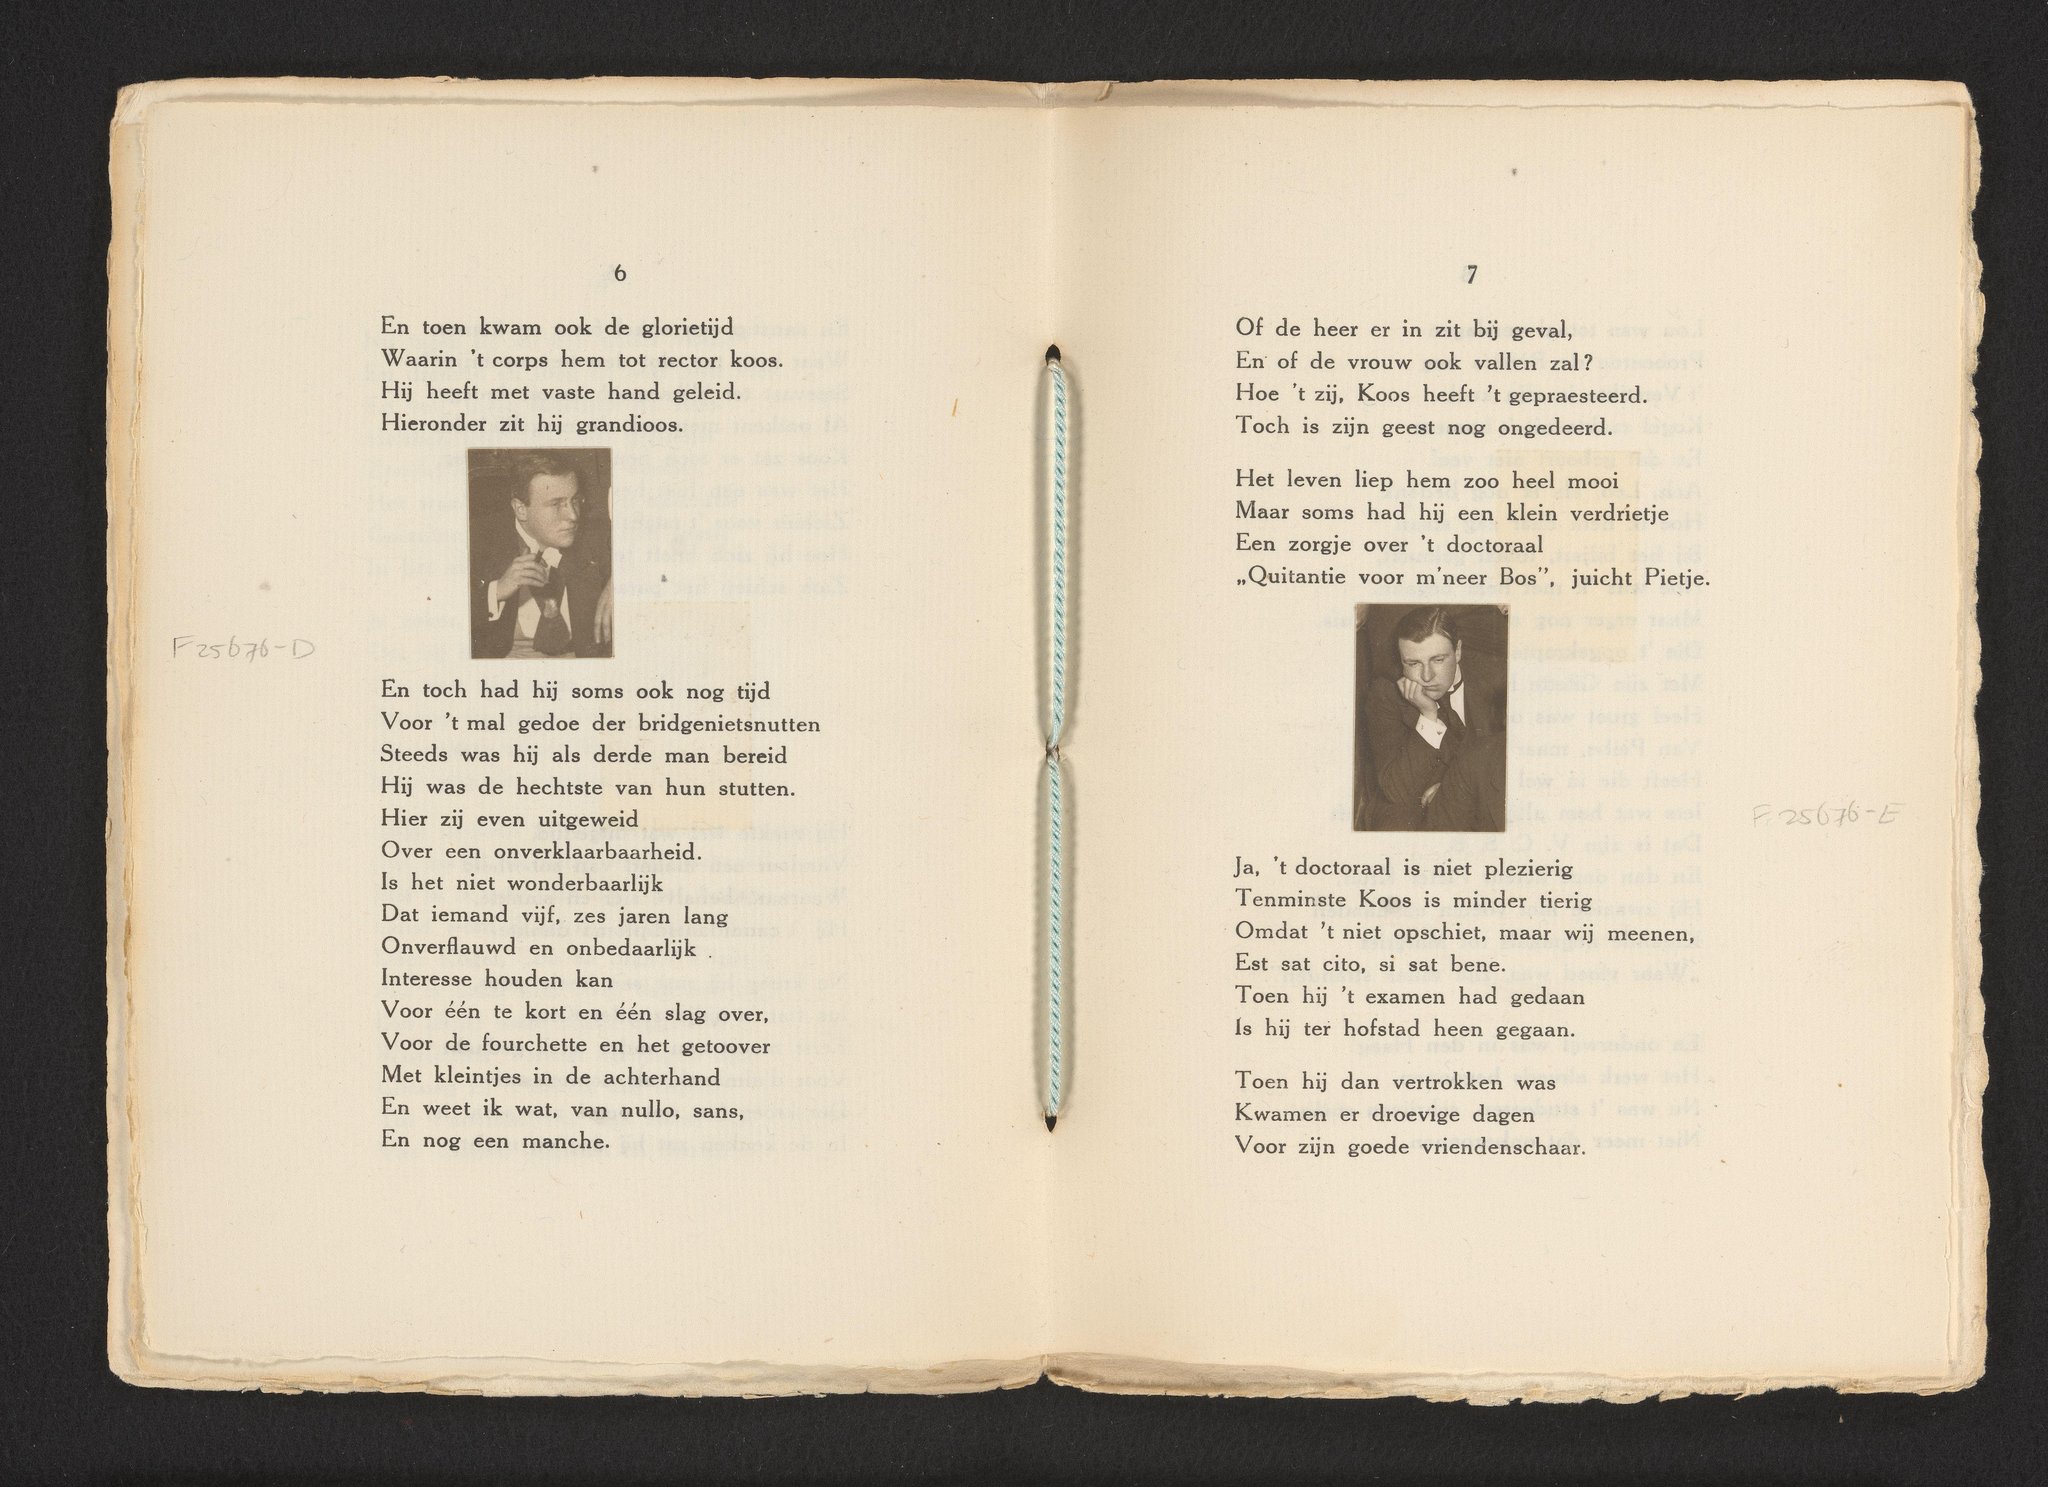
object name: page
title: Portret van Jacobo Willem Bos als student in melancholische stemming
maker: Anonymous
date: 1915-1925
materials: paper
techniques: gelatin silver print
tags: historical persons, youth, adolescent